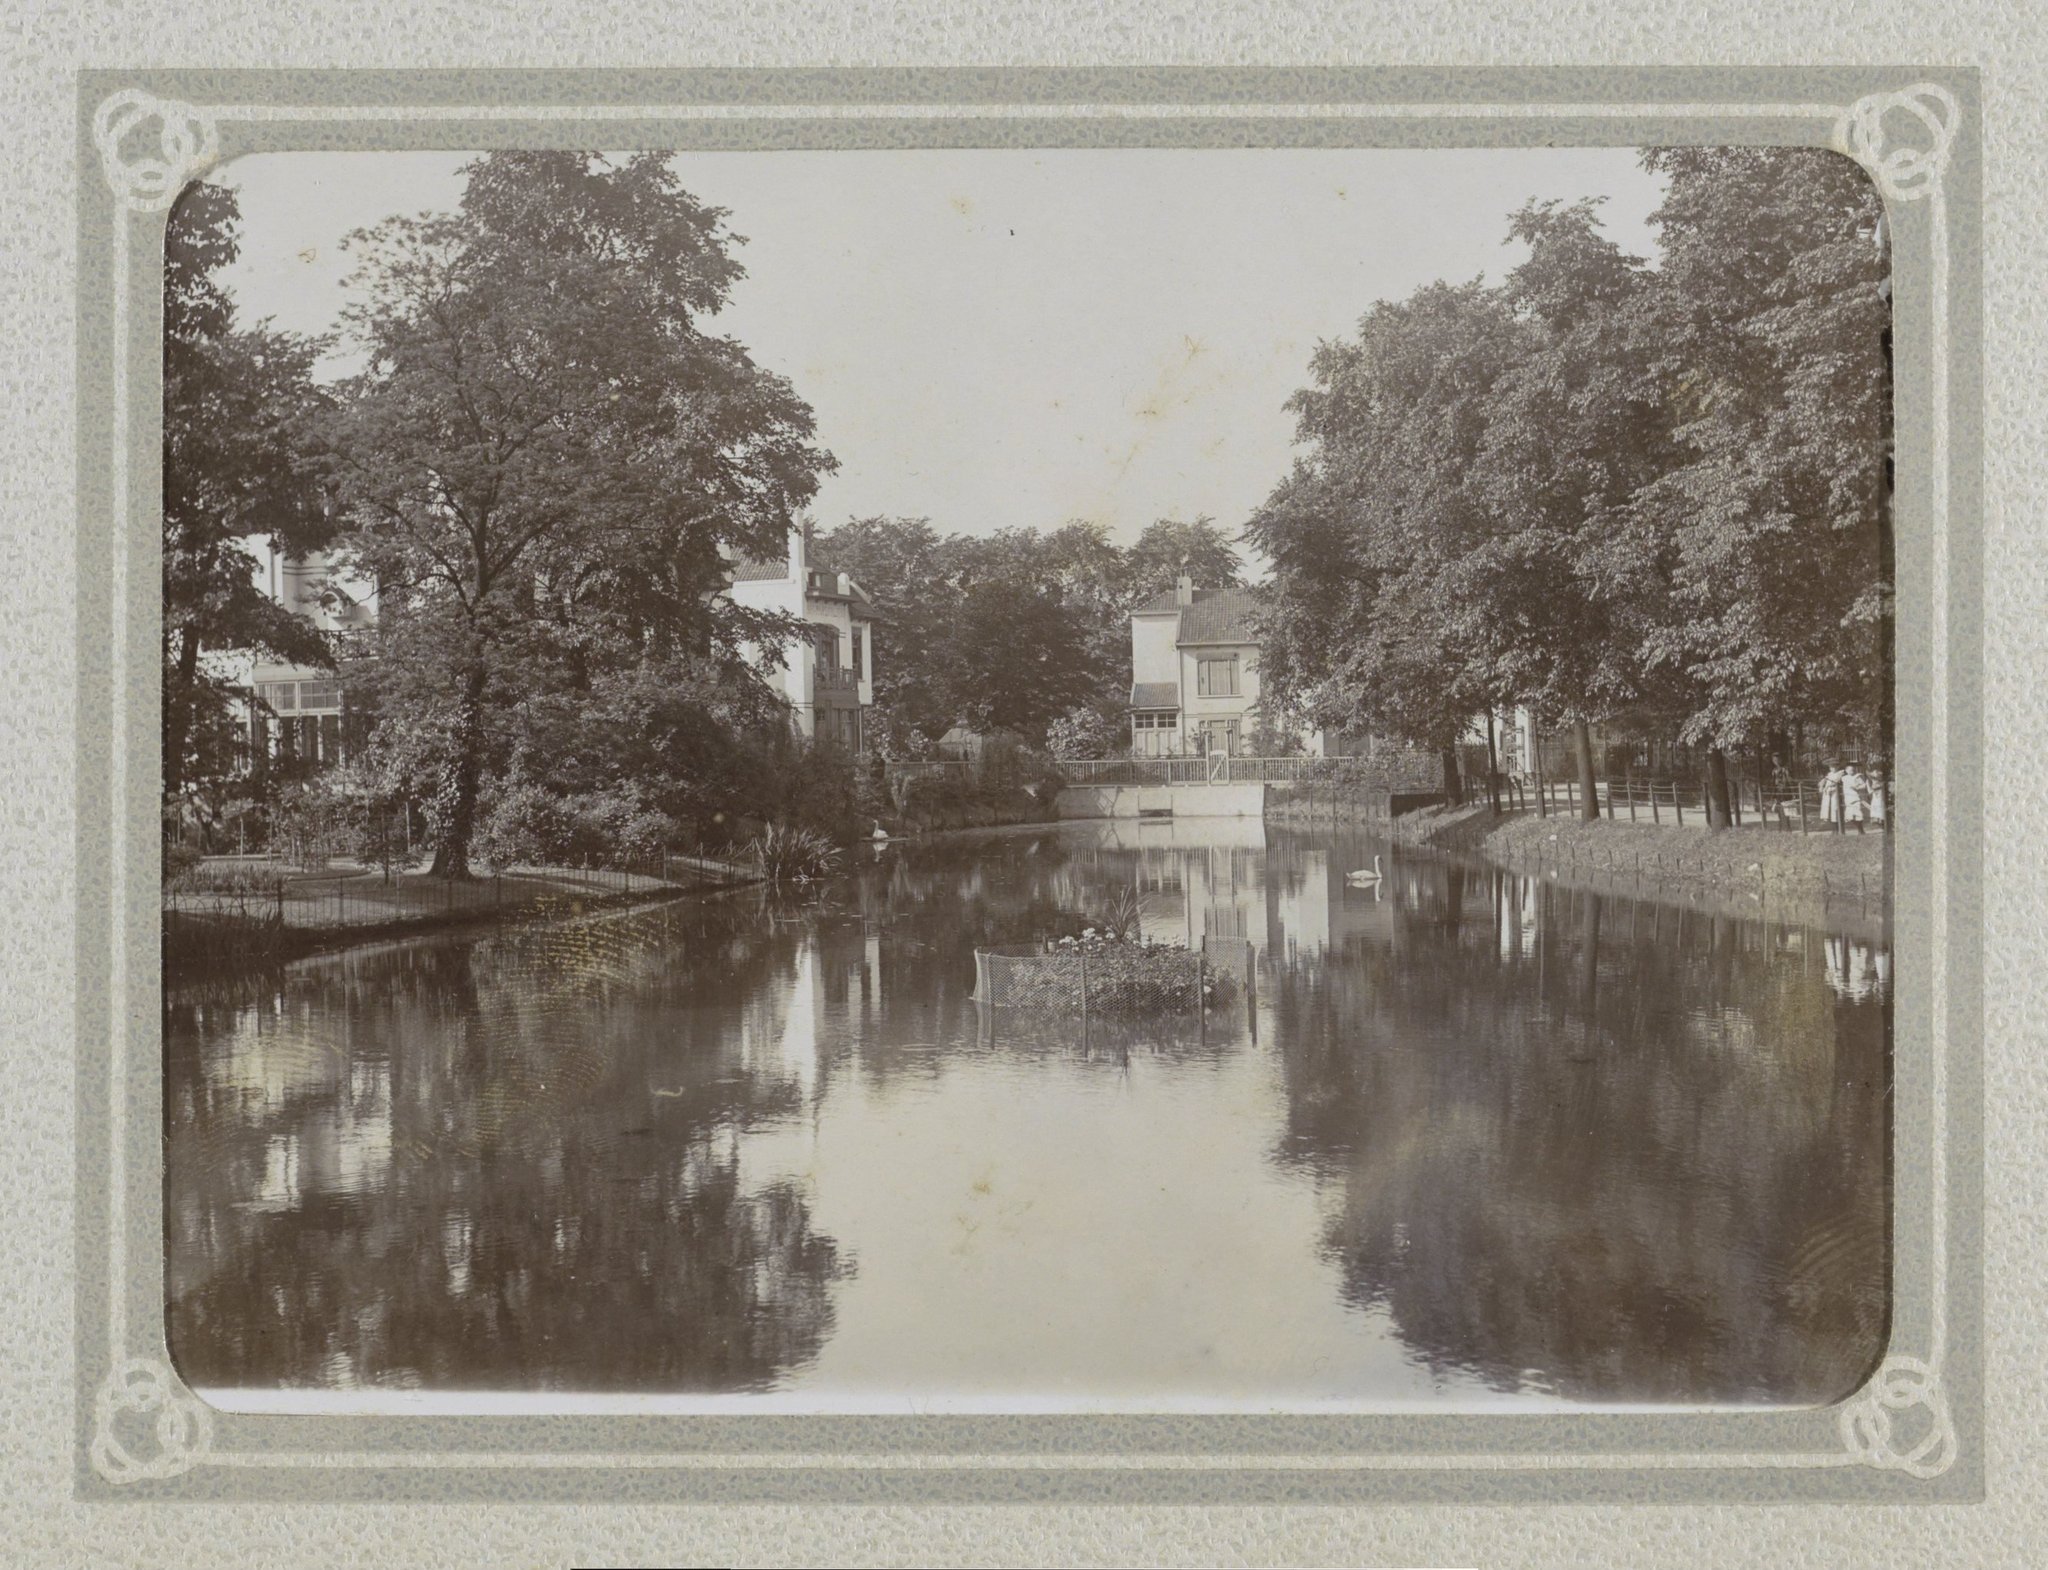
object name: photograph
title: Rotterdam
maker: folkert idzes de jong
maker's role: architect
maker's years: 1877-1929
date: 1905-1907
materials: photographic support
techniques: collodion silver print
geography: netherlands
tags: public gardens, park (+ city(-scape) with figures, staffage), rotterdam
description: Villa's aan de Vijverlaan in Park Honingen, Rotterdam. Op de voorgrond de kleine vijver. Onderdeel van Topografisch album van Nederlandse dorpen en steden 1905.